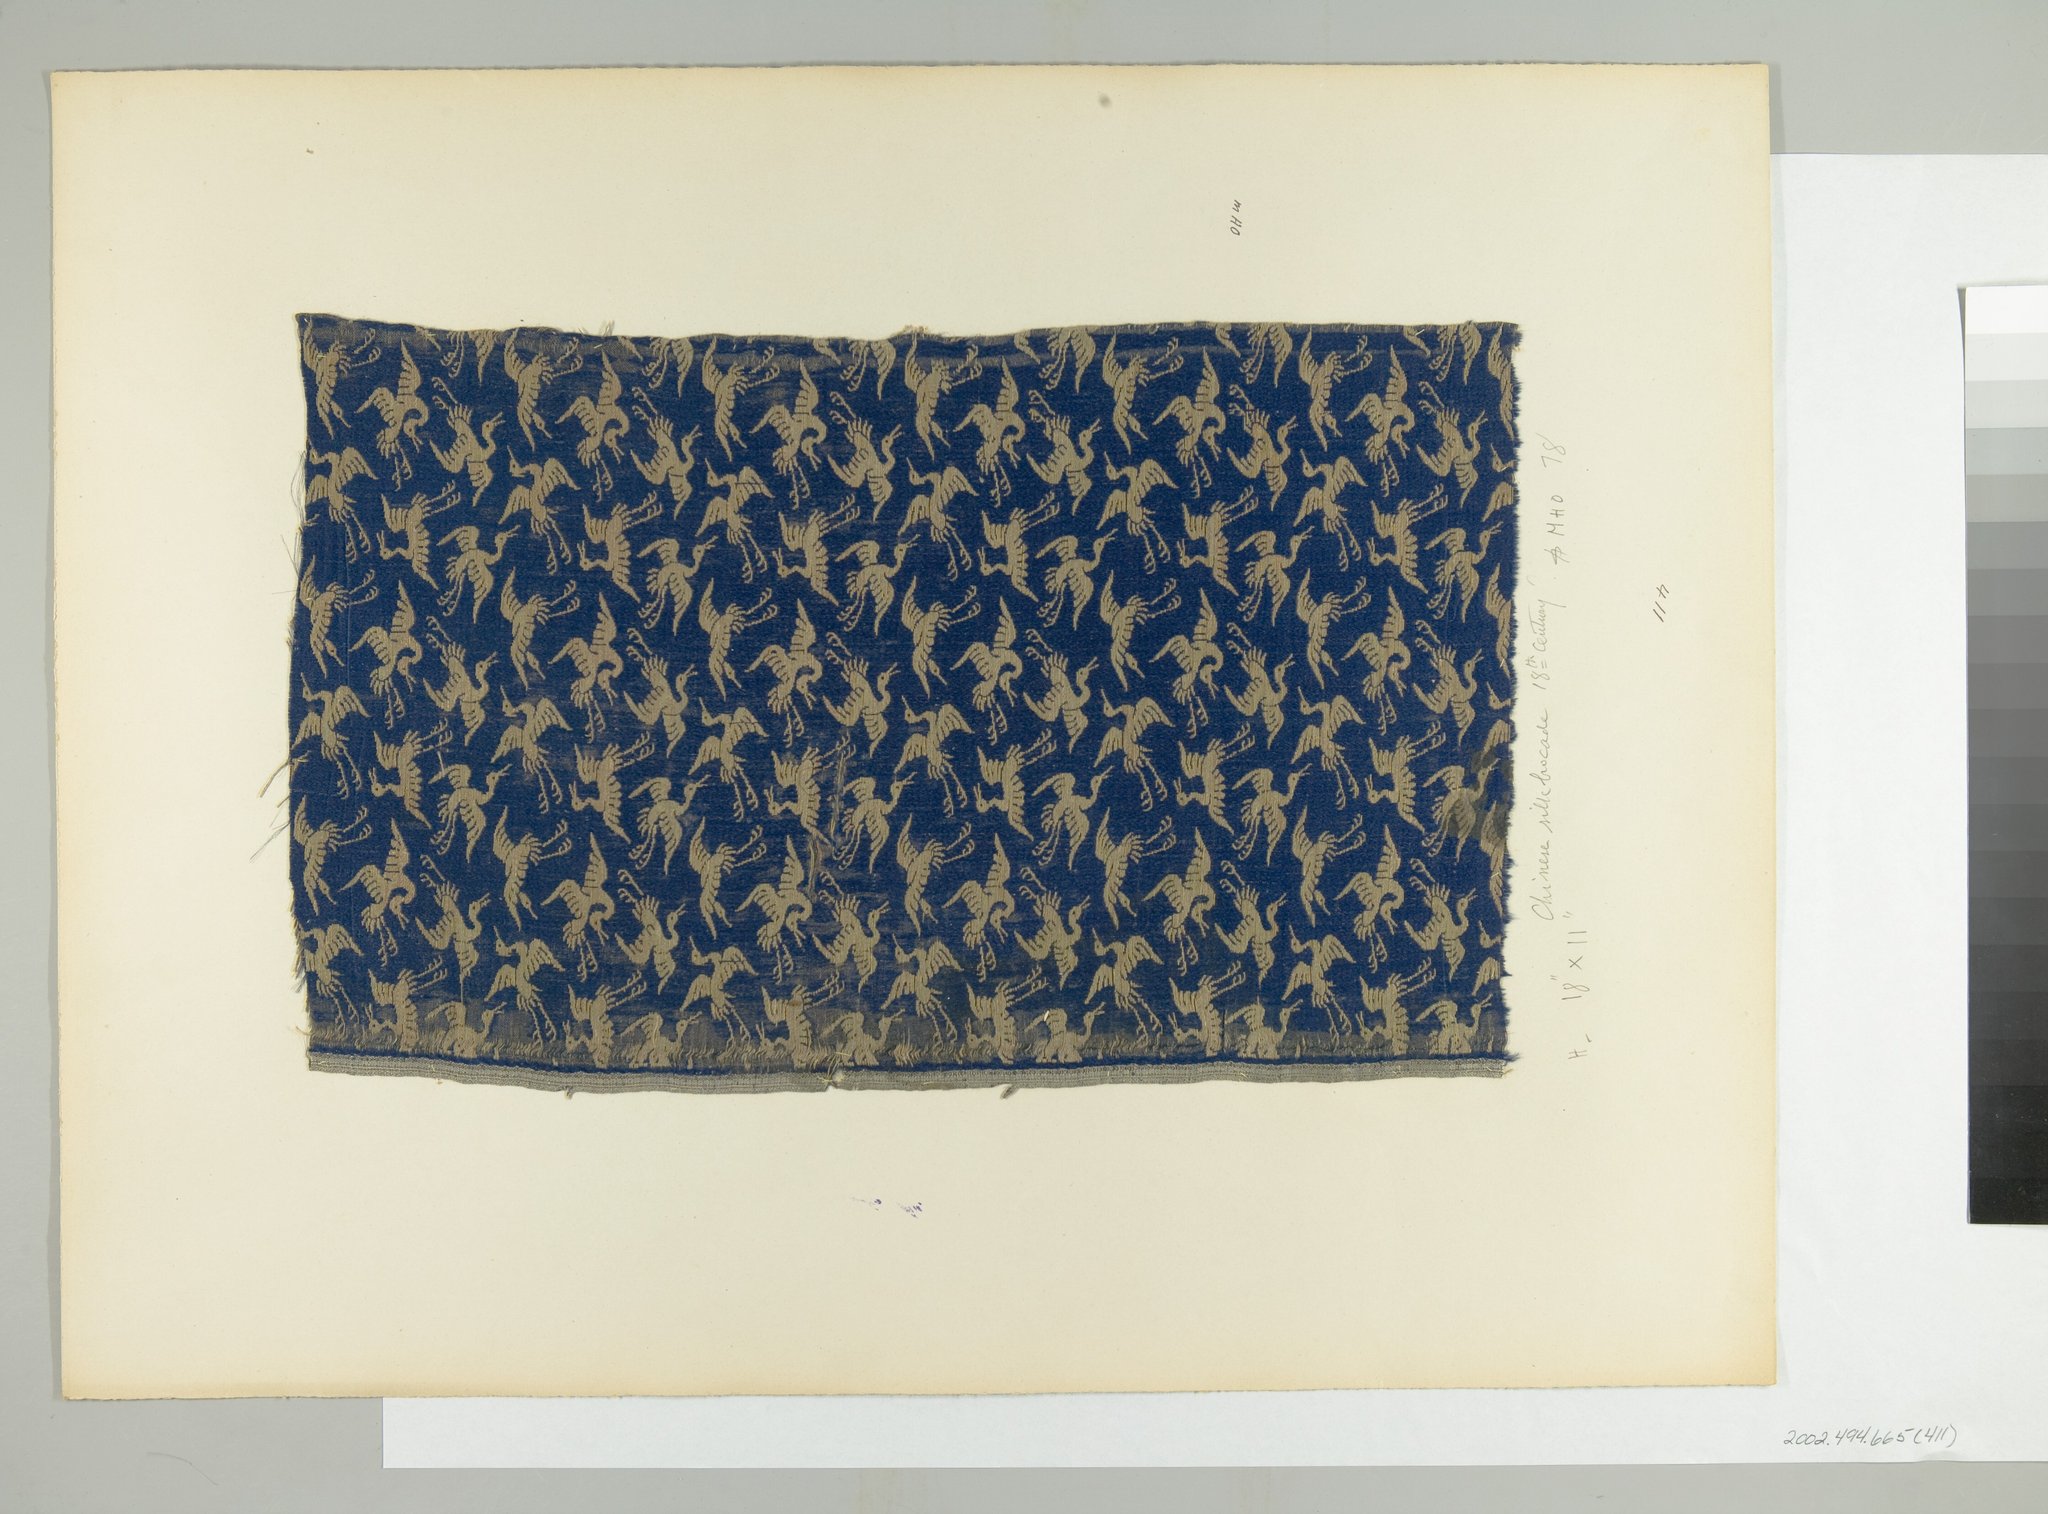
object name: piece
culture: japanese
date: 1615-1868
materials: metal thread, silk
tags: cranes